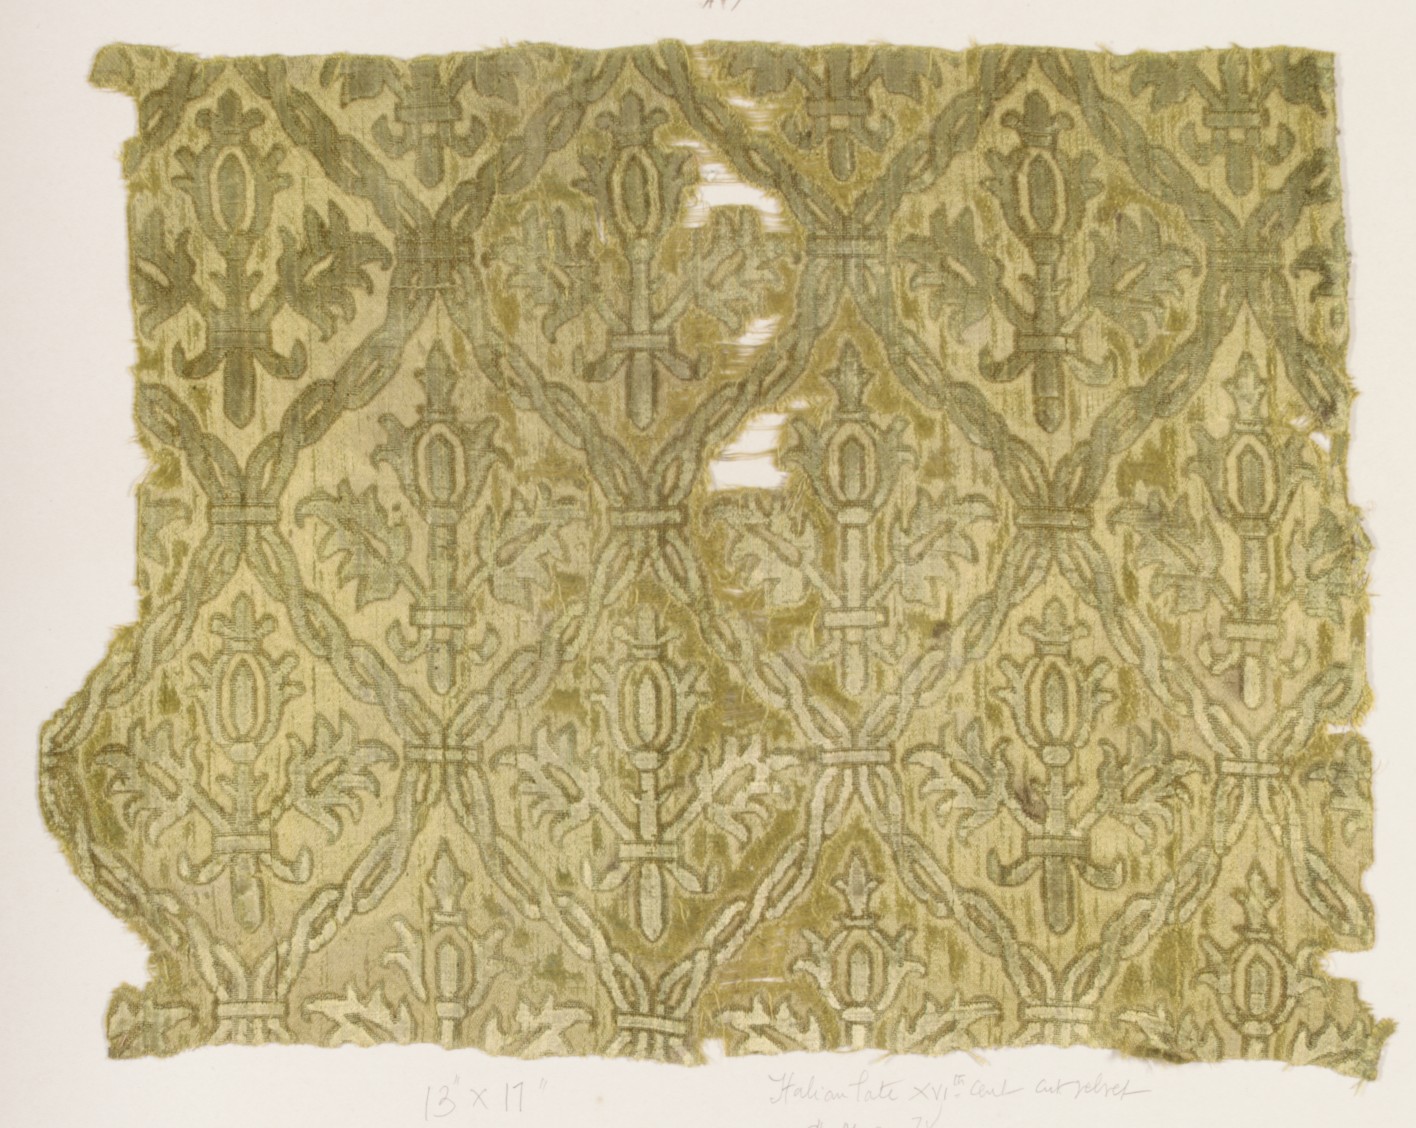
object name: fragment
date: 1567-1600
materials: silk